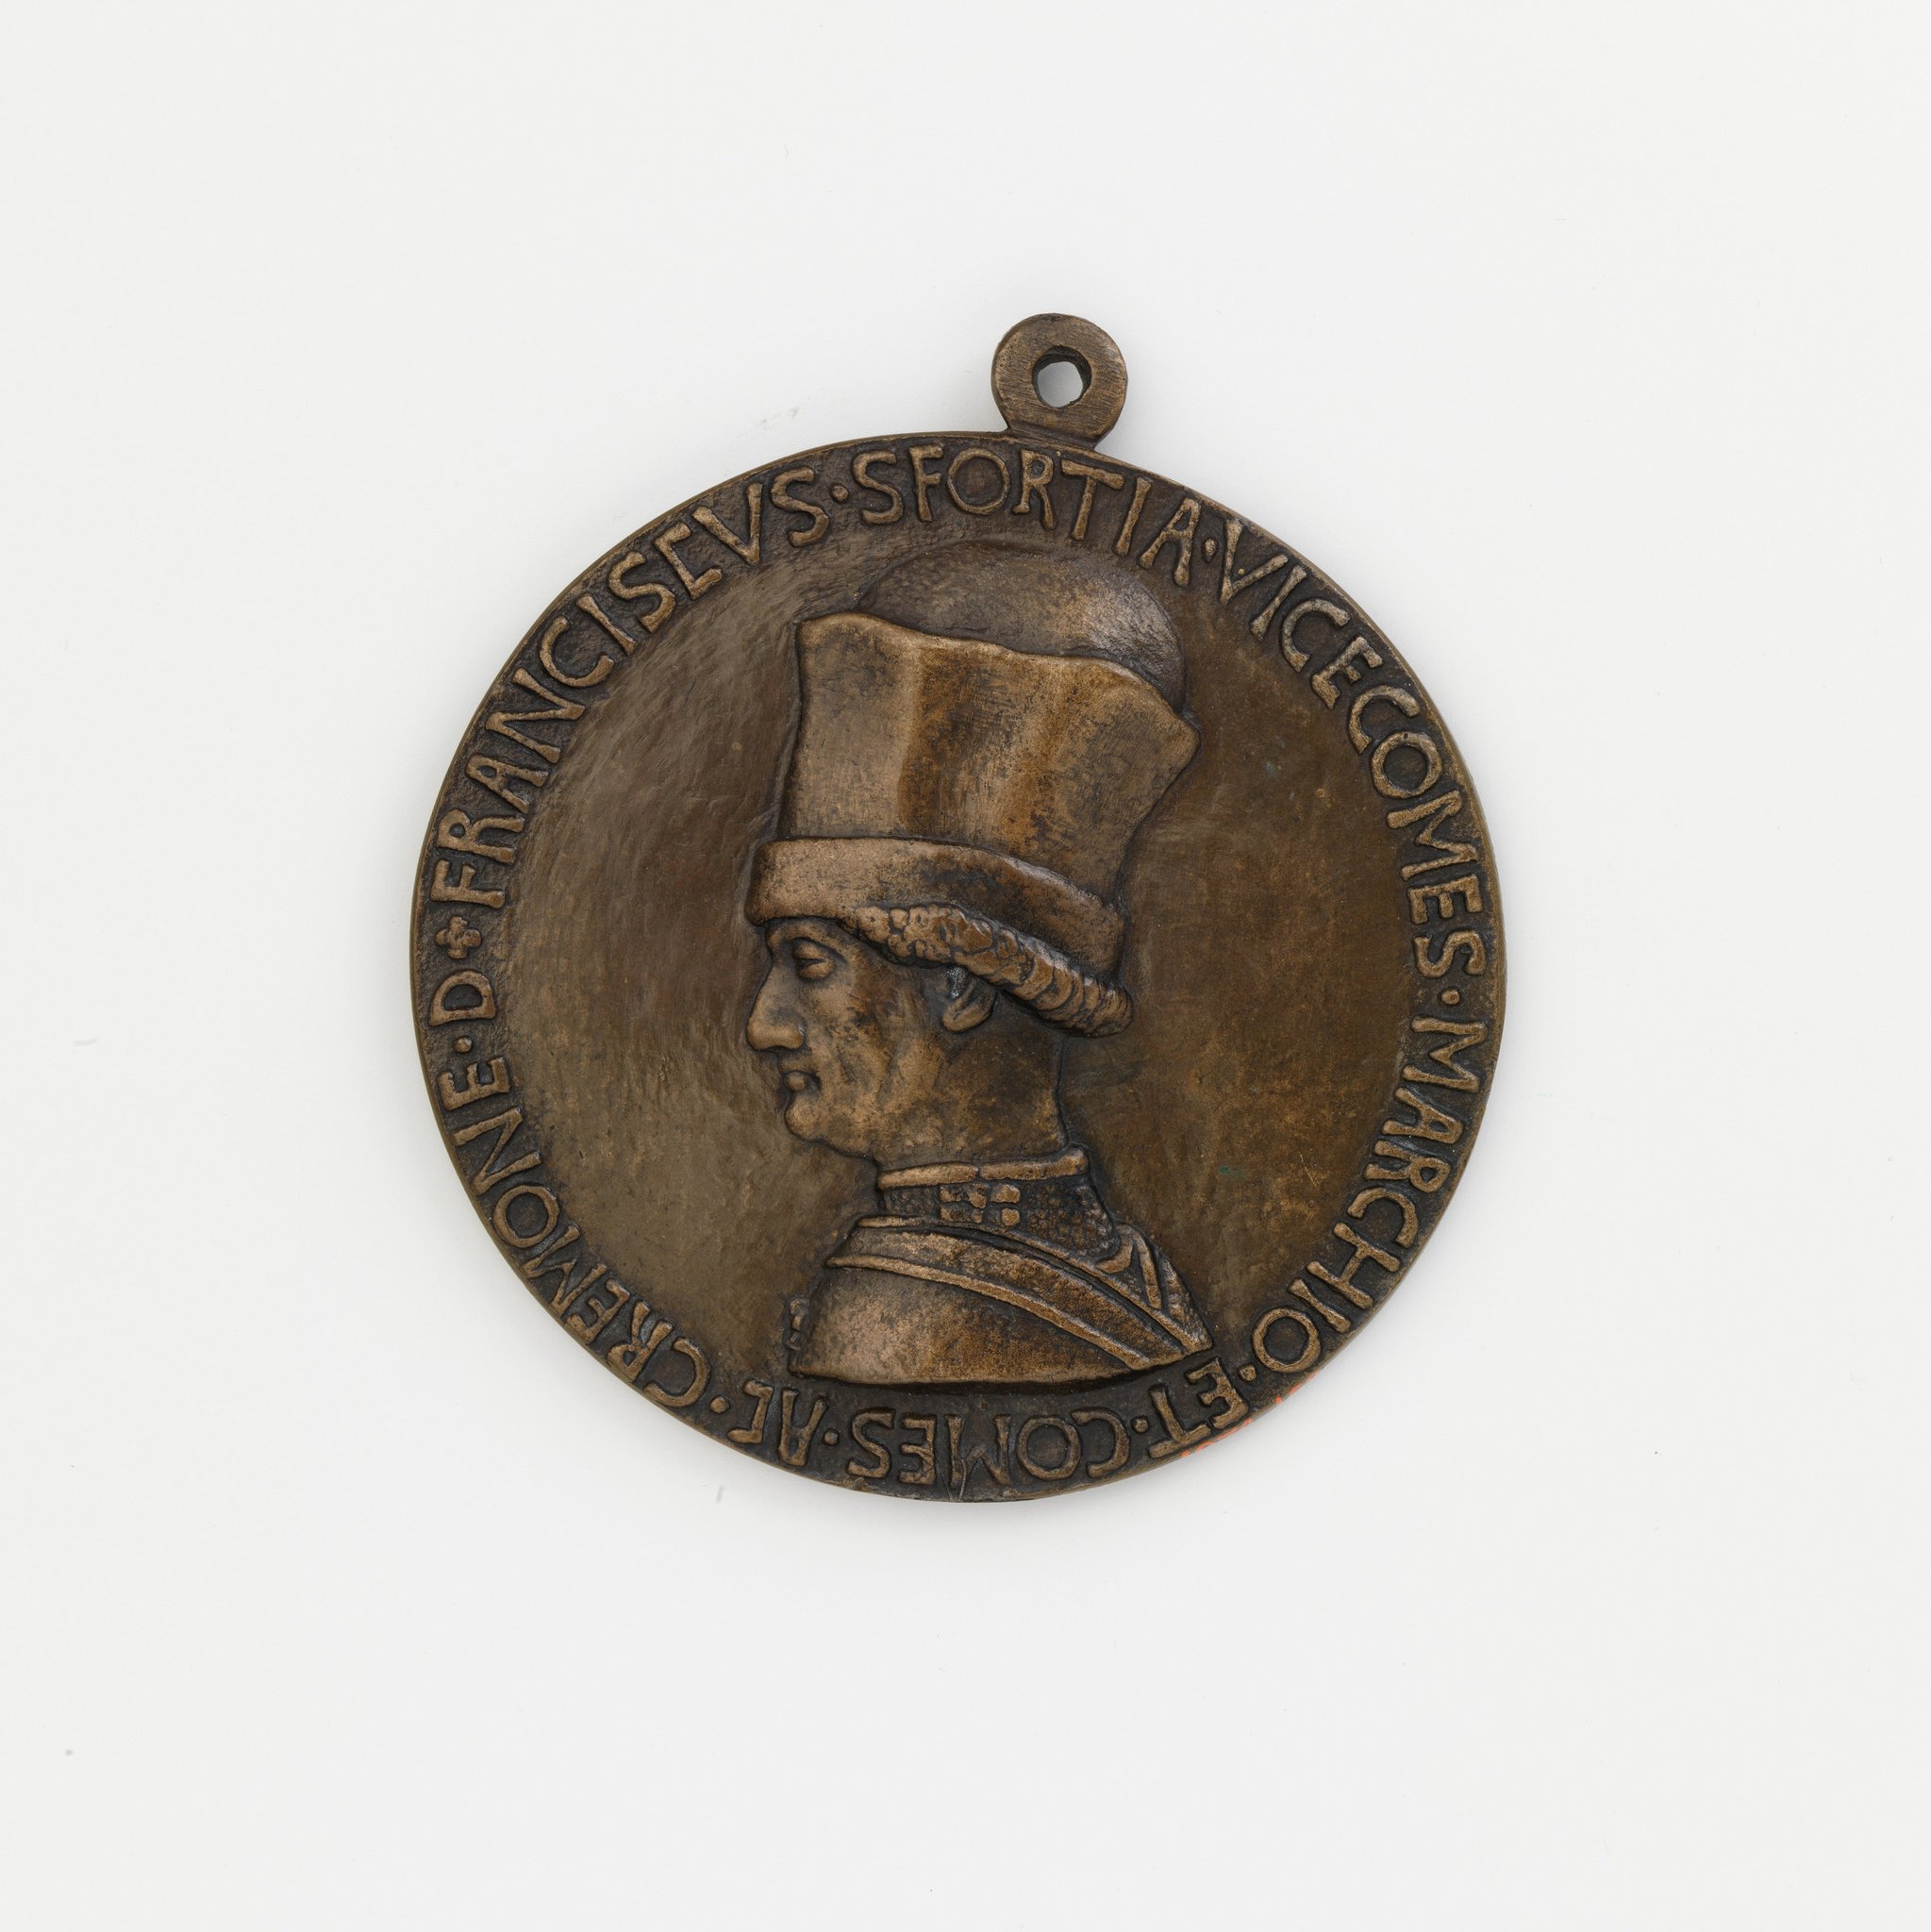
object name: medal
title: Francesco Sforza (1401–1466)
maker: pisanello (antonio pisano)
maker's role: artist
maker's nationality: italian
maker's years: 1395-1455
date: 1441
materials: bronze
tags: men,profiles